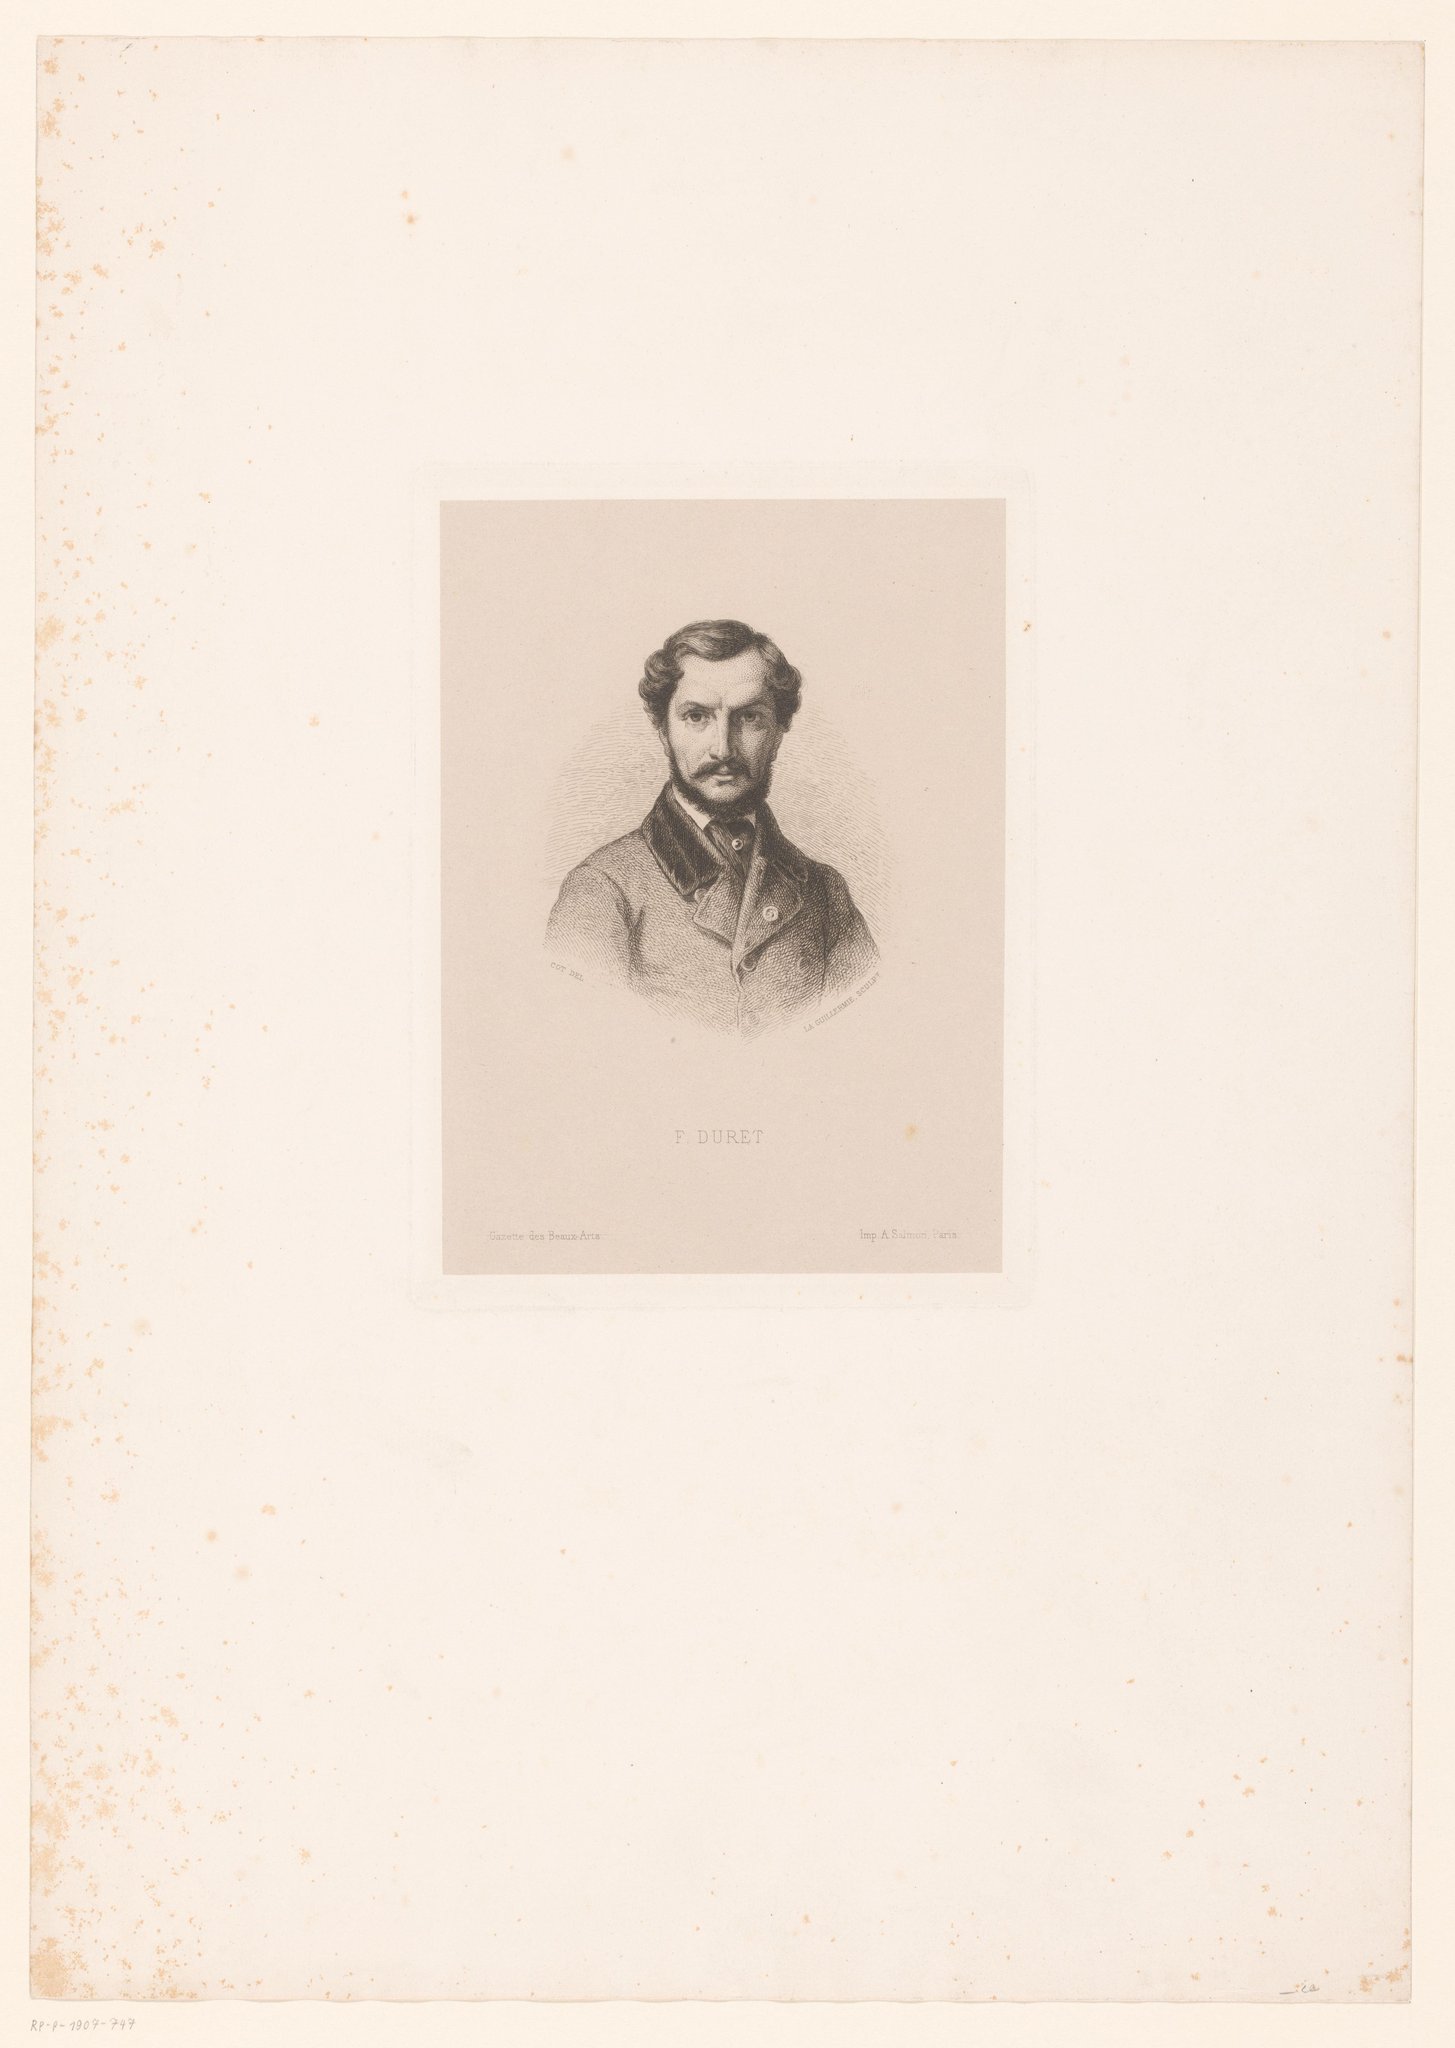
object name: print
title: F. Duret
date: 1851-1907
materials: paper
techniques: drypoint, engraving, etching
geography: paris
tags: paris, sculptor, françois-joseph duret, portrait, self-portrait of sculptor, historical persons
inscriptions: collector's mark: Lugt 2228